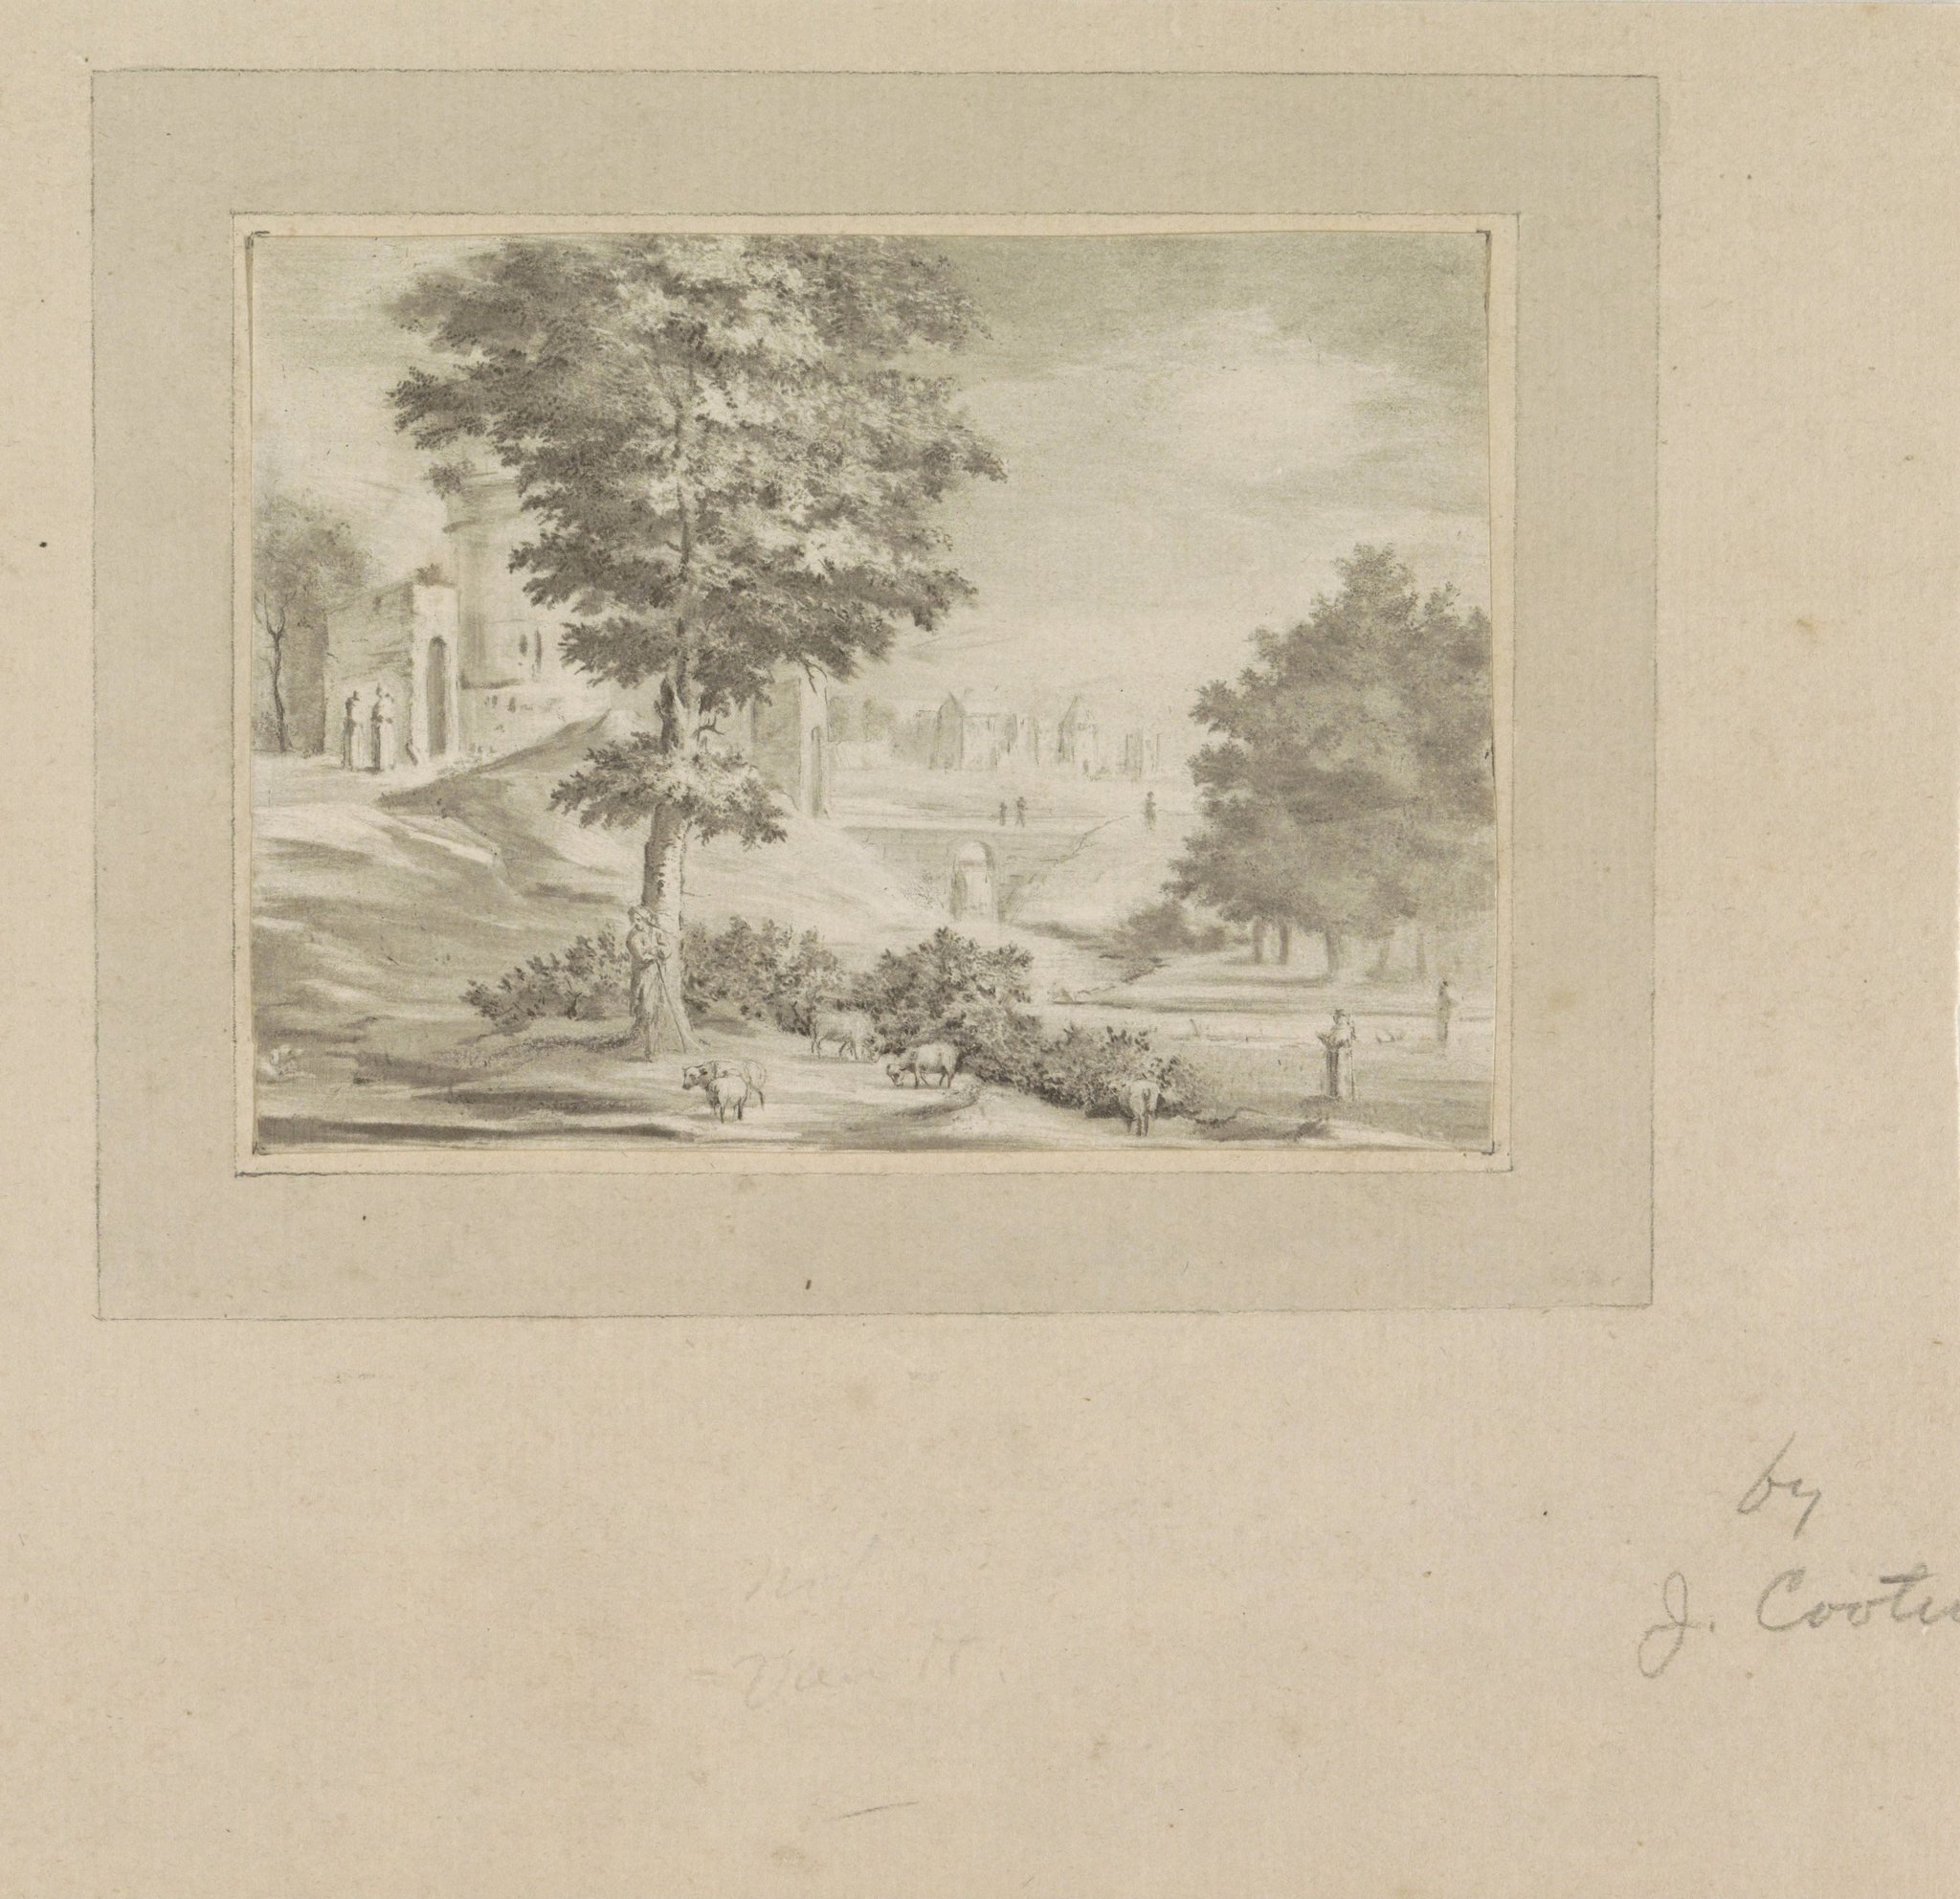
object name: print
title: Landschap met herder en schapen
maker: jurriaan cootwijck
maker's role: print maker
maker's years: 1714-1798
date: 1724-1798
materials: paper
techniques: transfer, print drawing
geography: amsterdam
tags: herding, herdsman, herdswoman, shepherd, shepherdess, cowherd, etc., sheep, landscape with bridge, viaduct or aqueduct (+ city(-scape) with figures, staffage)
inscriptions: collector's mark: Lugt 2228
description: Landschap met een stad op de achtergrond. Op de voorgrond staat een herder tegen een boom. Rondom hem grazen zijn schapen.